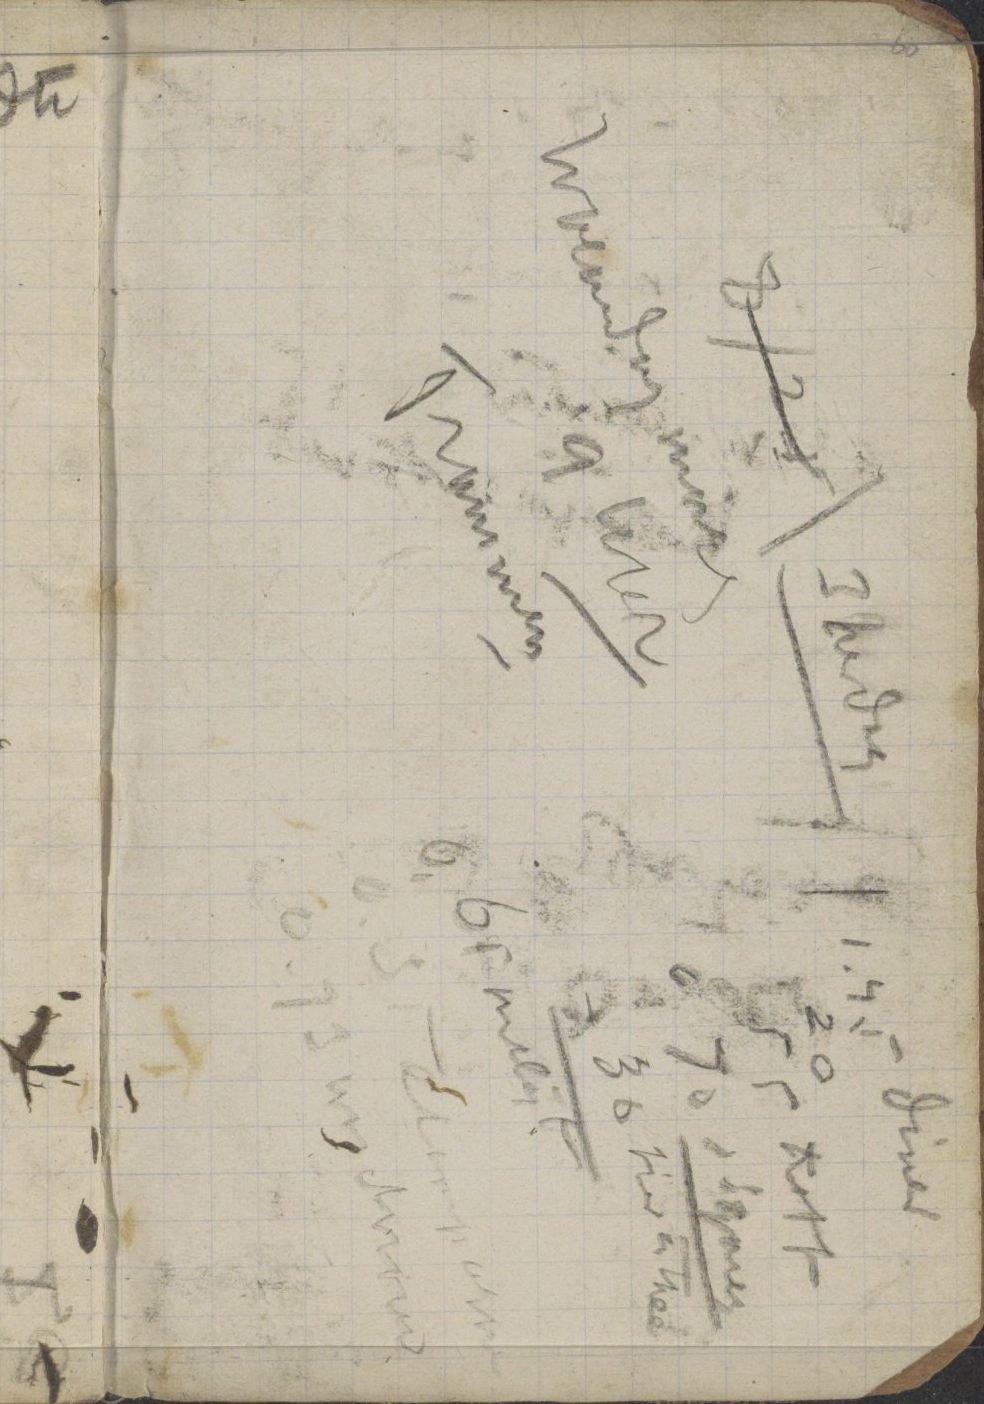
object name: sketchbook leaf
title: Annotaties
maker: george hendrik breitner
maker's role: draughtsman, painter, print maker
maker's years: 1857-1923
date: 1893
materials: pencil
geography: amsterdam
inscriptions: annotation, annotation: ‘Woensdag morgen/ 9 uren/ Trammen’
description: Pagina 60 uit een schetsboek met 30 bladen vervaardigd in Amsterdam.